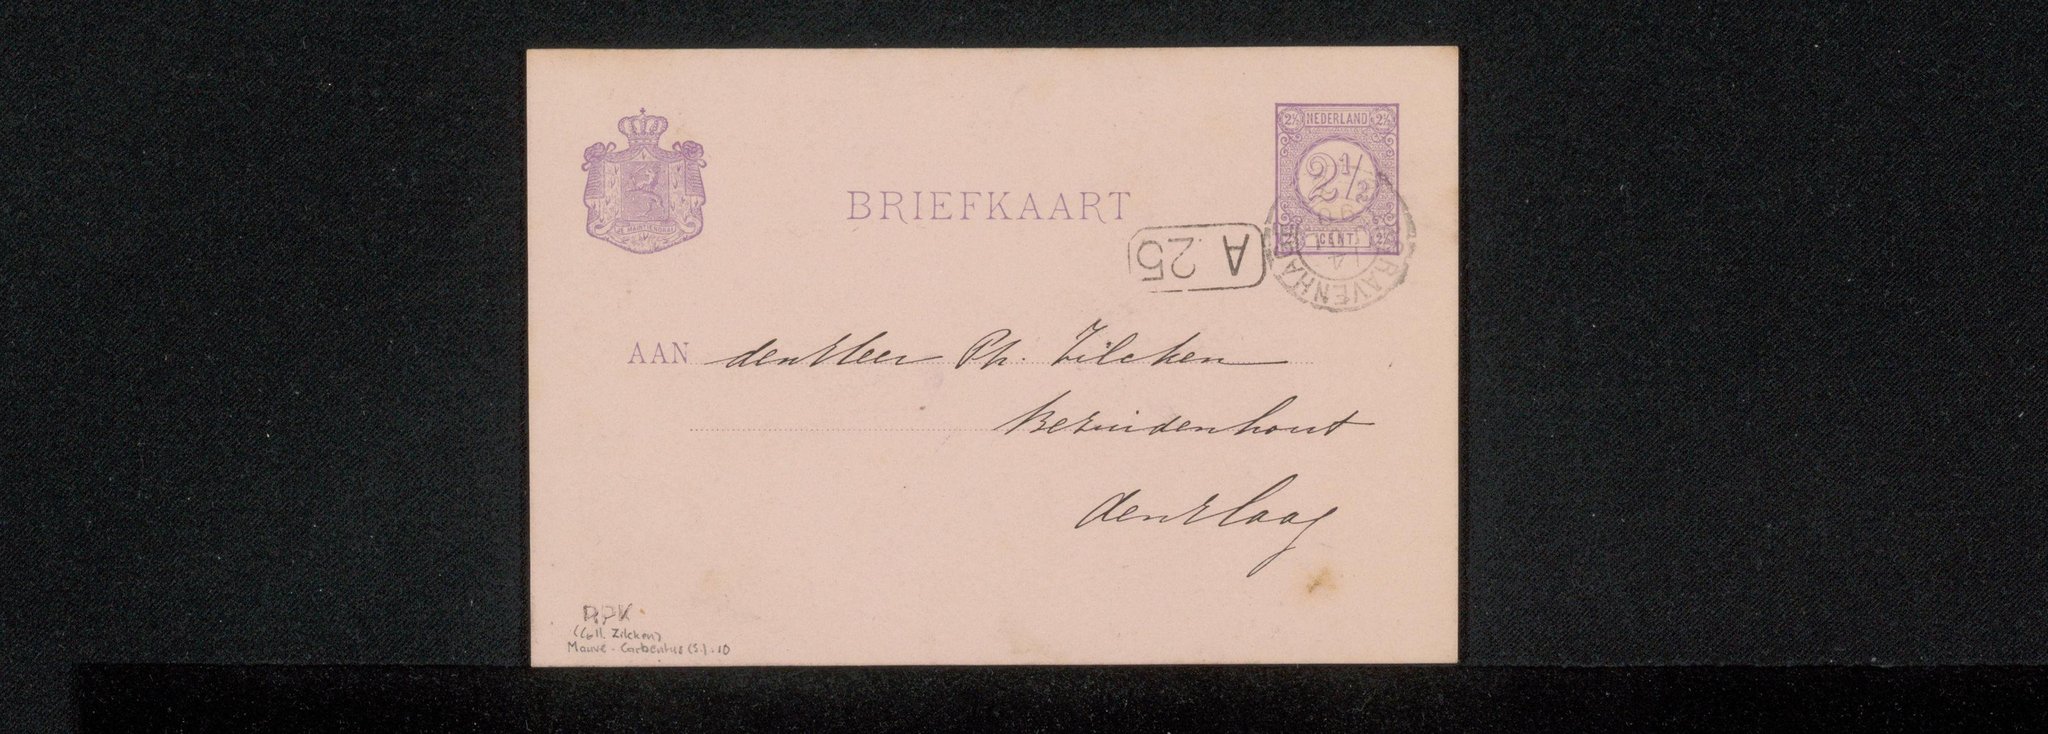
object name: postcard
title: Briefkaart aan Philip Zilcken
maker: ariette sophia jeannette mauve-carbentus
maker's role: draughtsman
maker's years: 1856-1894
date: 1890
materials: cardboard, ink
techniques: pen, writing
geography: the hague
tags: painter, draughtsman, philip zilcken, drawing, exhibition ~ art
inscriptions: collector's mark: ‘RPK’